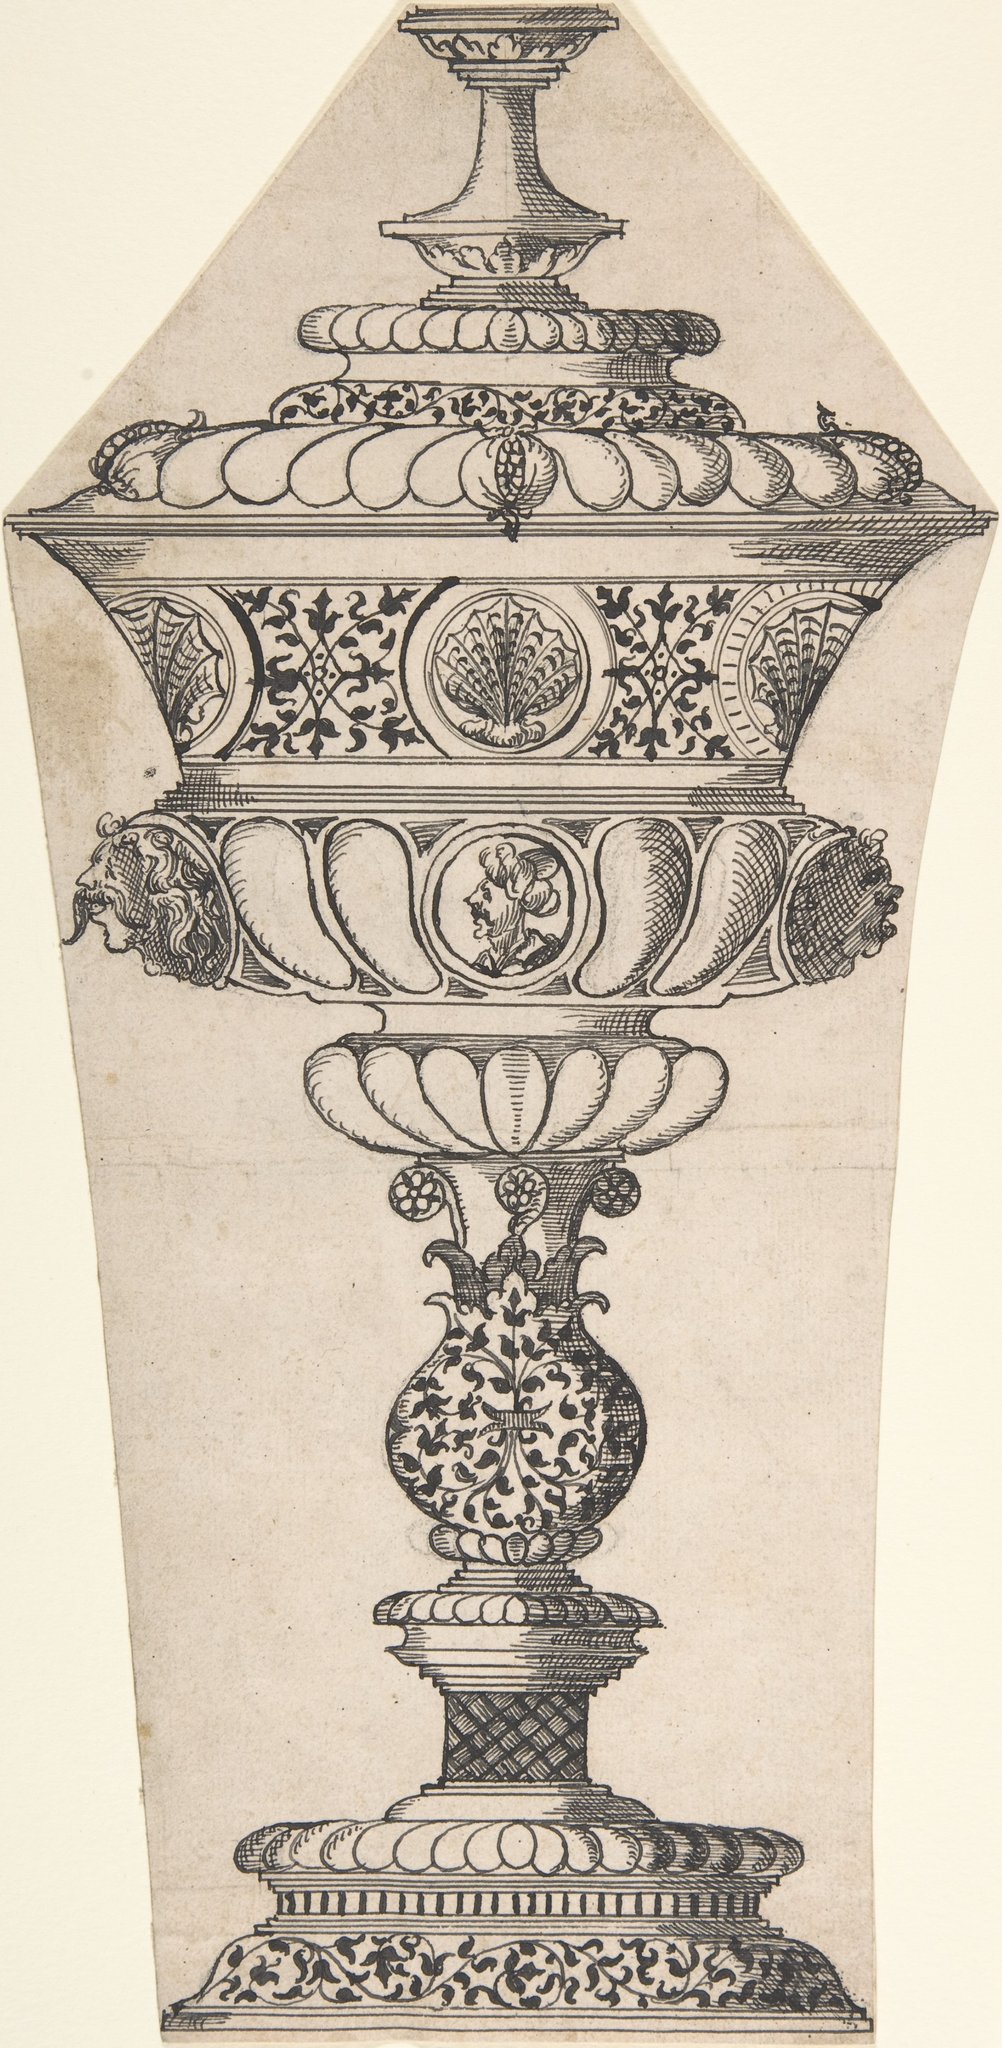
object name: drawing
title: Covered Cup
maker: anonymous, italian, 19th century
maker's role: artist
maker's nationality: italian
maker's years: 1800-1900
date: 1800-1900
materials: ink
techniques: pen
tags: cups